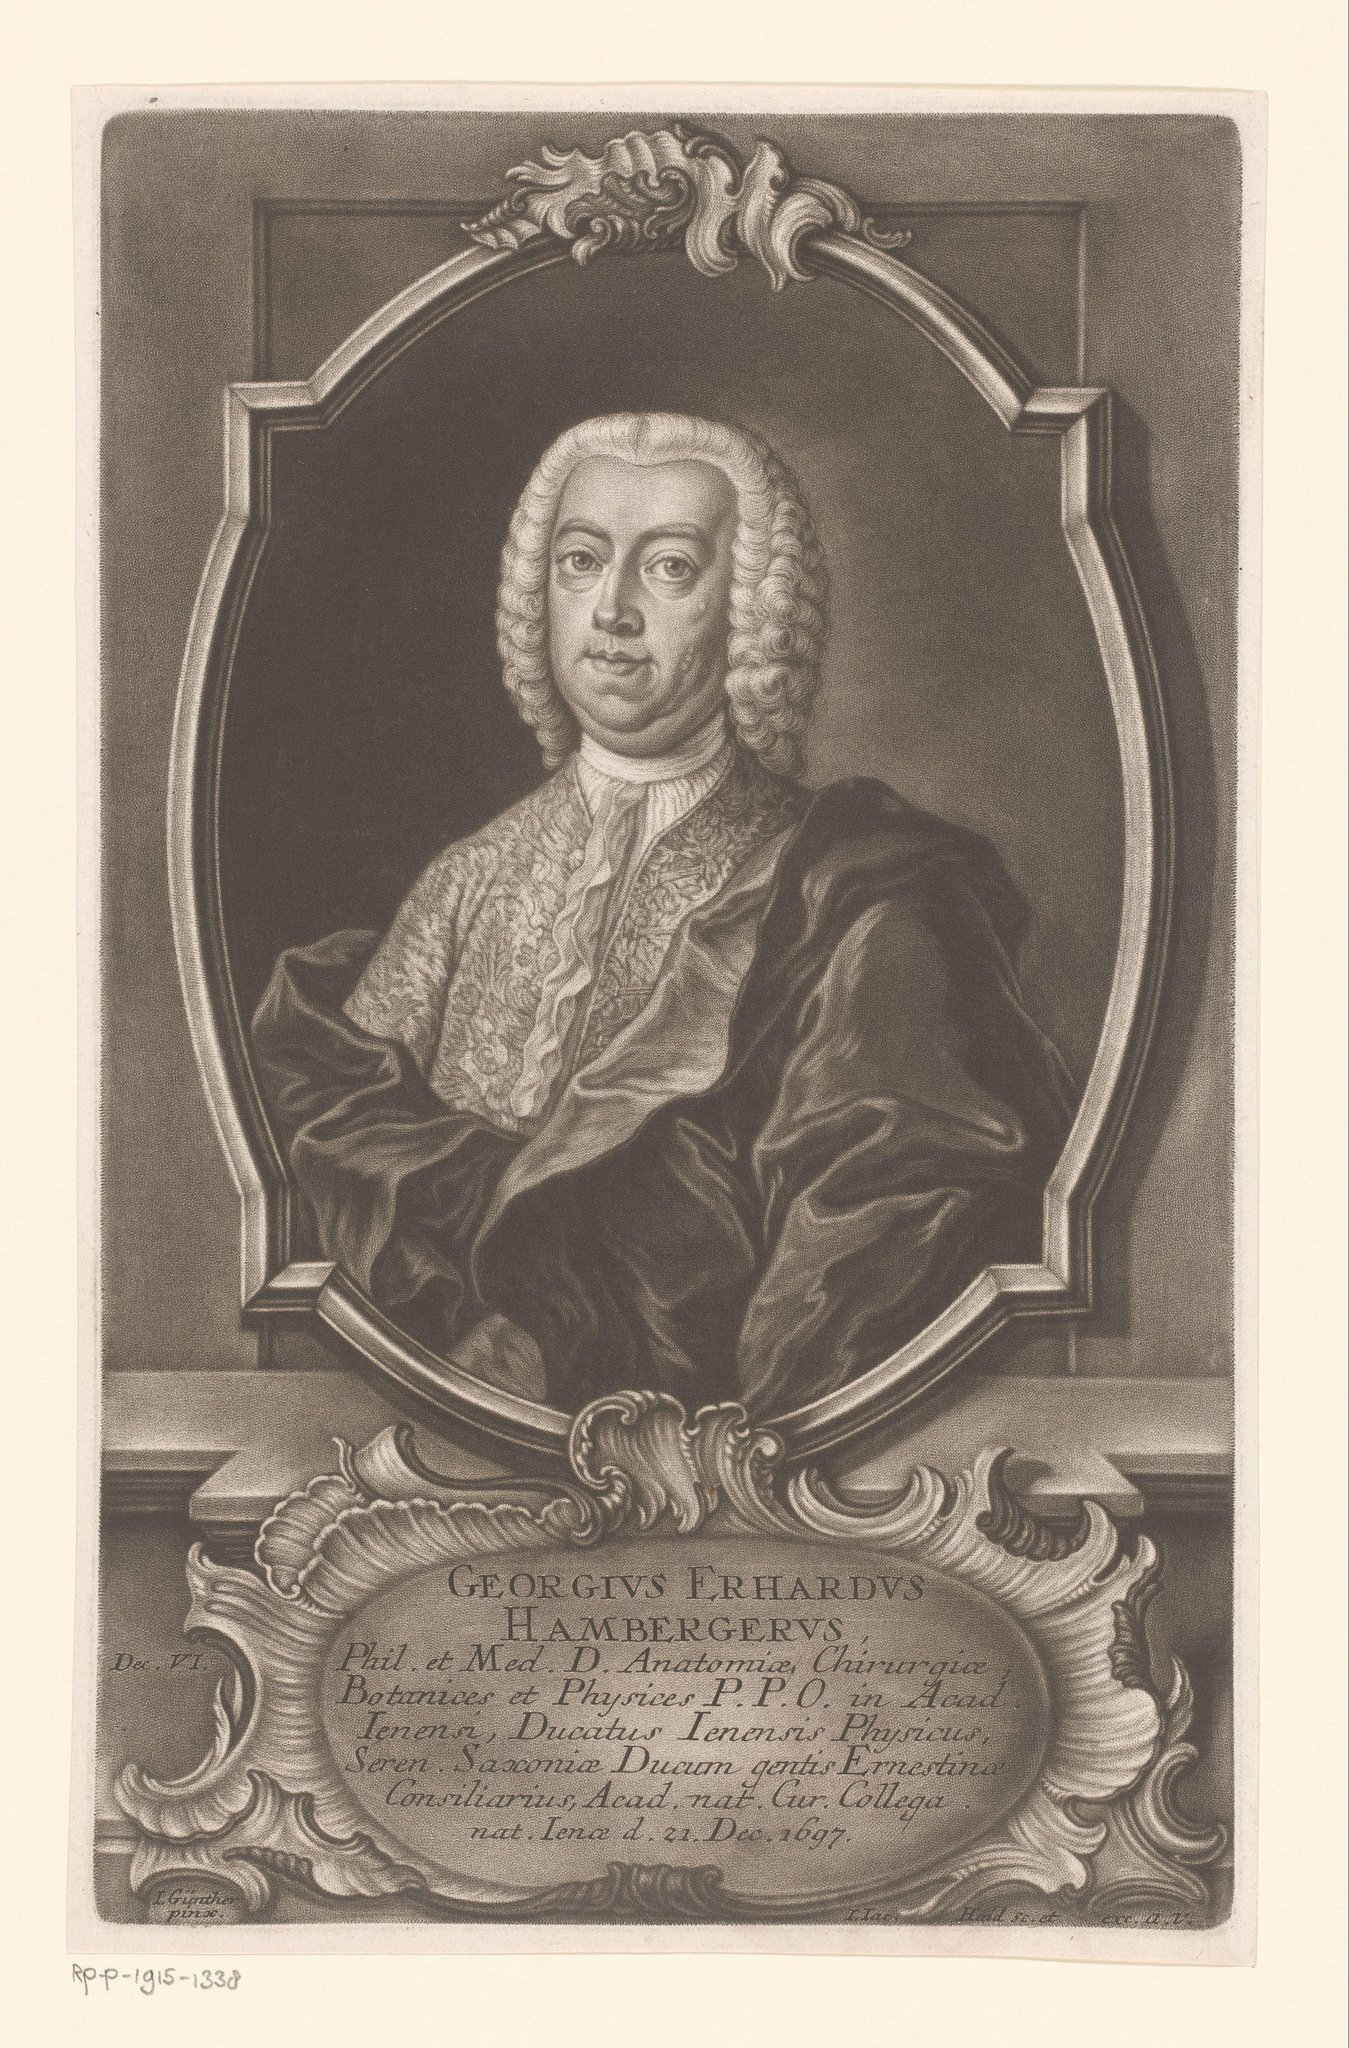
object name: print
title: Portret van Georg Erhard Hamberger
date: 1747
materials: paper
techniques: mezzotint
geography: augsburg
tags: physicist, rocaille ornament, historical persons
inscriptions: collector's mark: Lugt 2228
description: Prent gebruikt voor: Brucker, Jacob. Bildersal heutiges Tages lebender und durch Gelahrheit berühmter Schrifftsteller. Augsburg: Johann Jacob Haid, 1747.